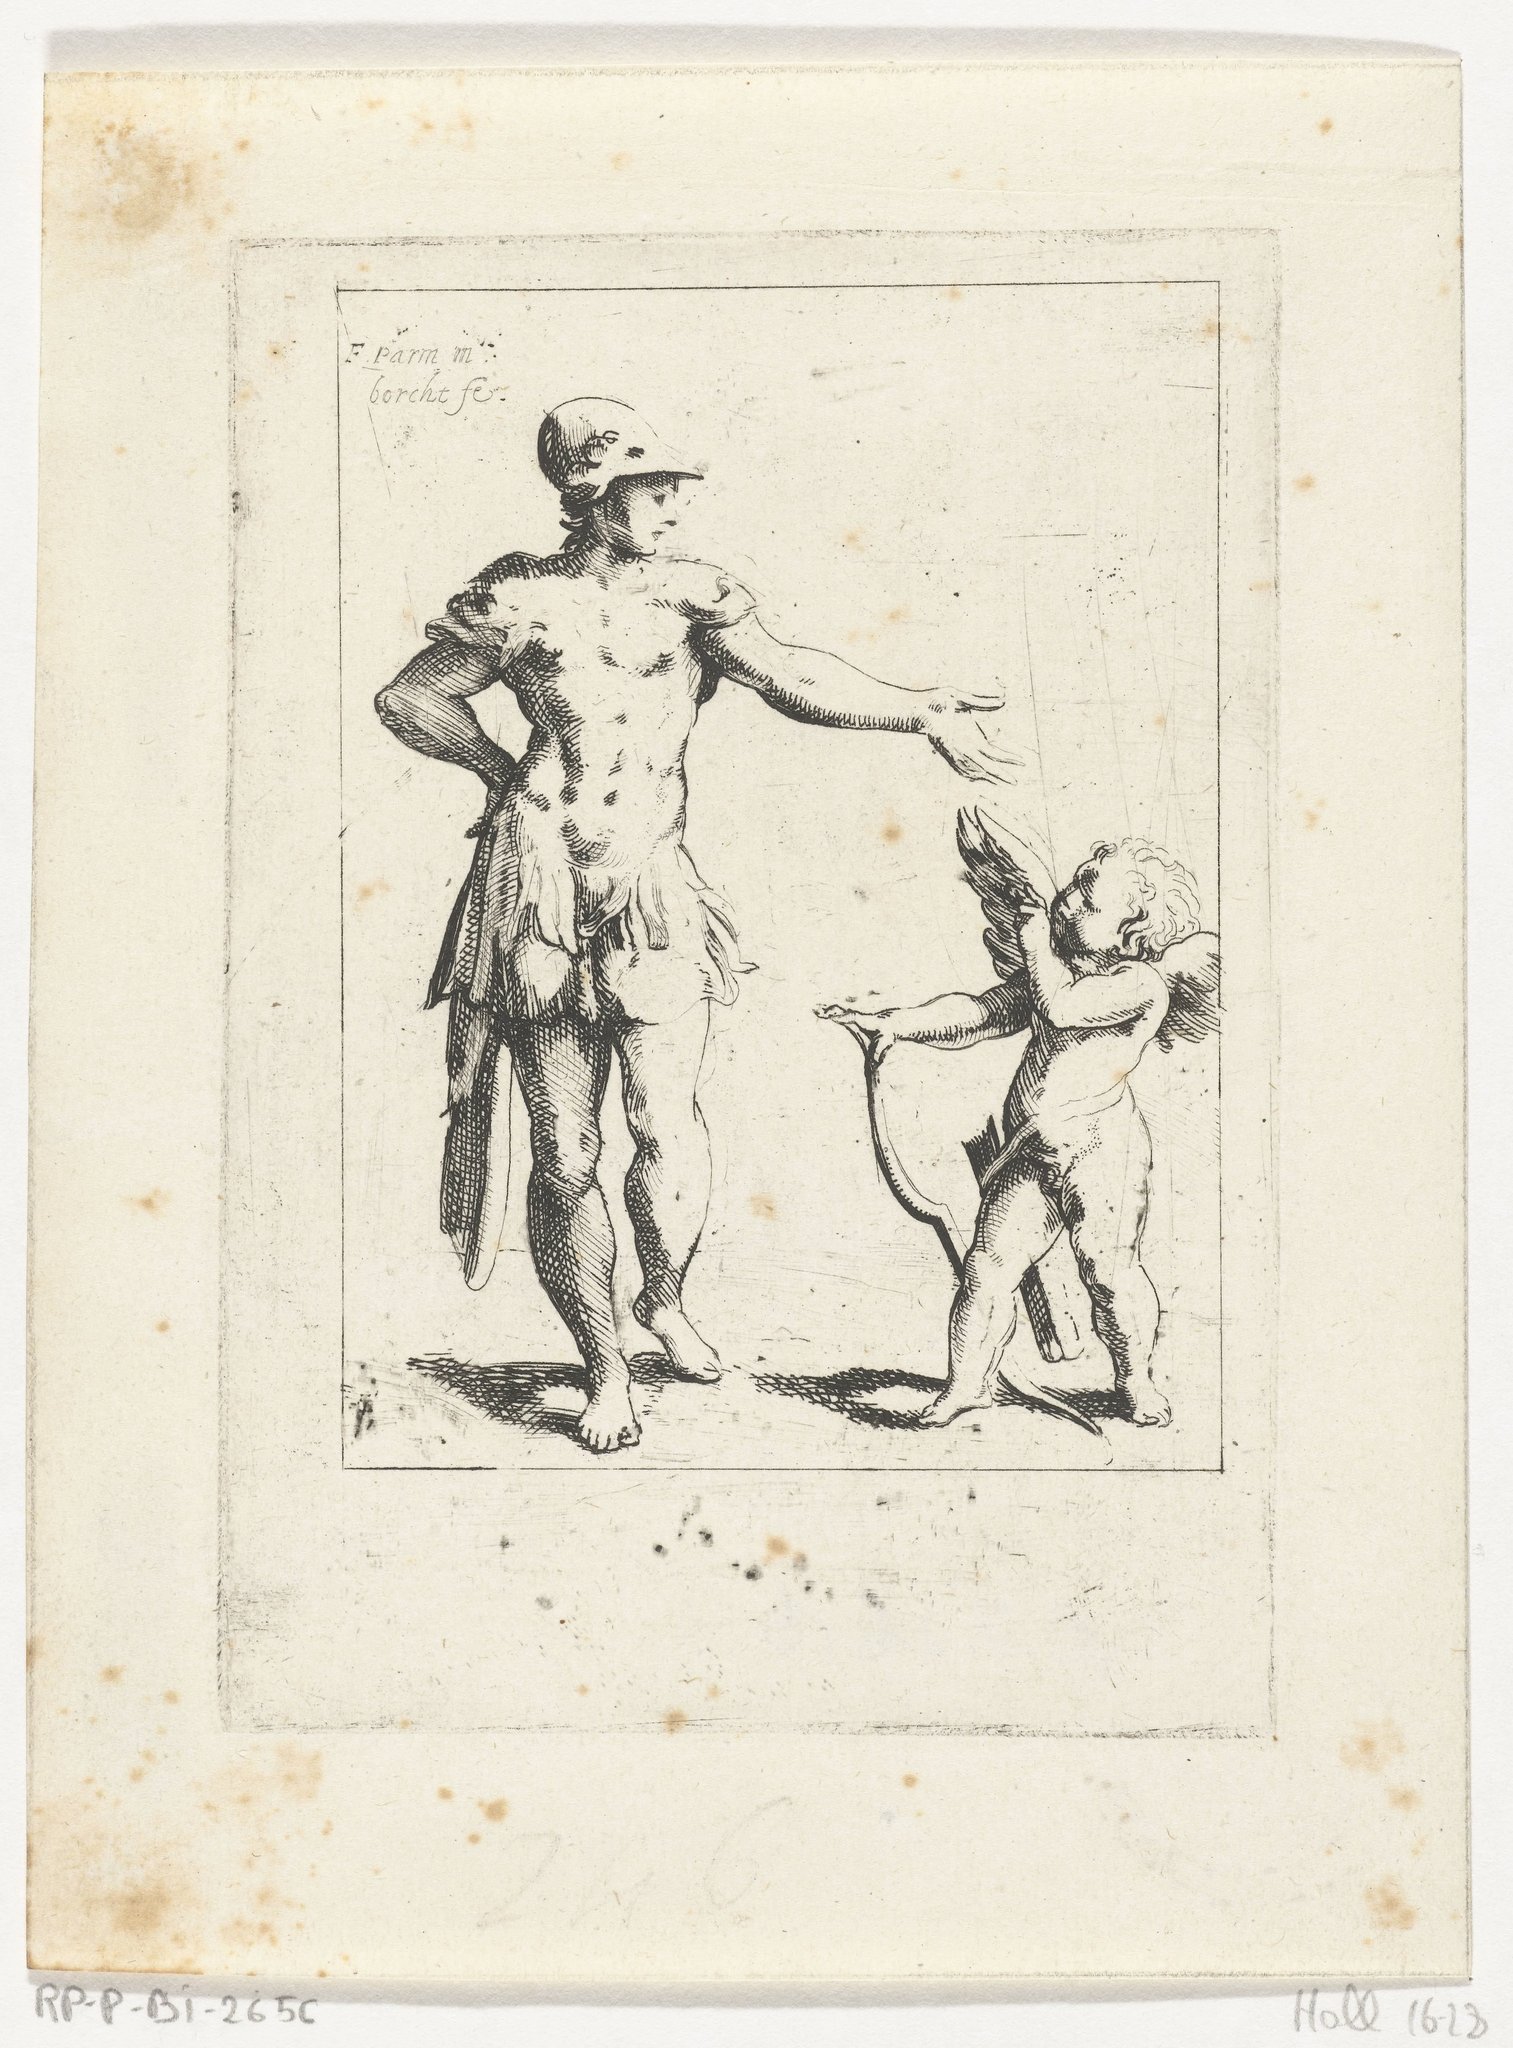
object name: print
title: Mars en Cupido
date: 1638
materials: paper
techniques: etching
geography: italy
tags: (story of) mars (ares), (story of) cupid, amor (eros)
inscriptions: collector's mark: Lugt 240 of 1838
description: Links staat de god Mars in volle wapenrusting. Met zijn linkerhand wijst hij naar Cupido. Rechts staat Cupido, met pijl en boog. Prent uit een serie naar diverse tekeningen van Parmigianino uit de collectie Arundel.